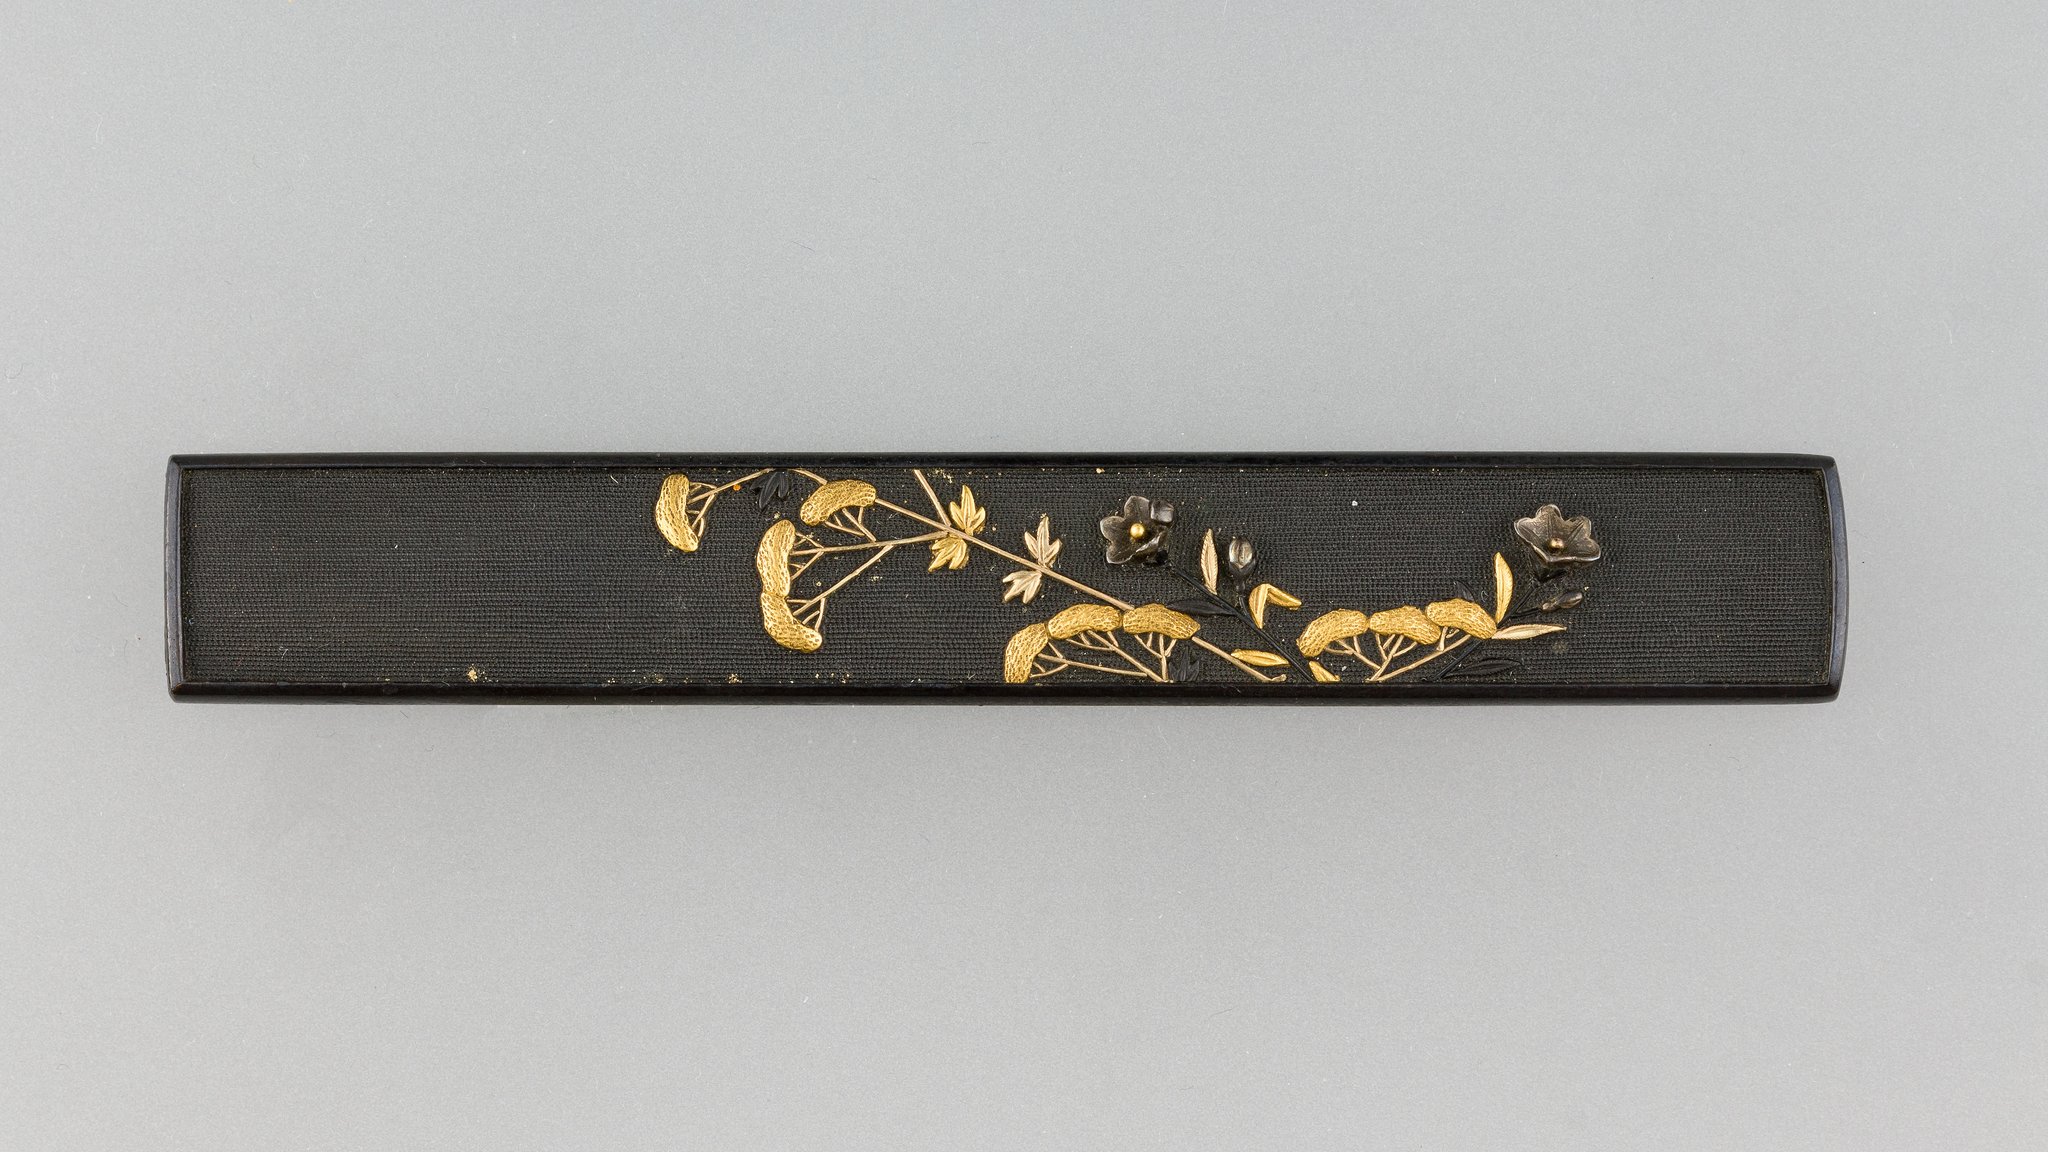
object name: knife handle kozuka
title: Knife Handle (Kozuka)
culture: japanese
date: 1701-1800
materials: gold alloy, gold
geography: japan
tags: plants